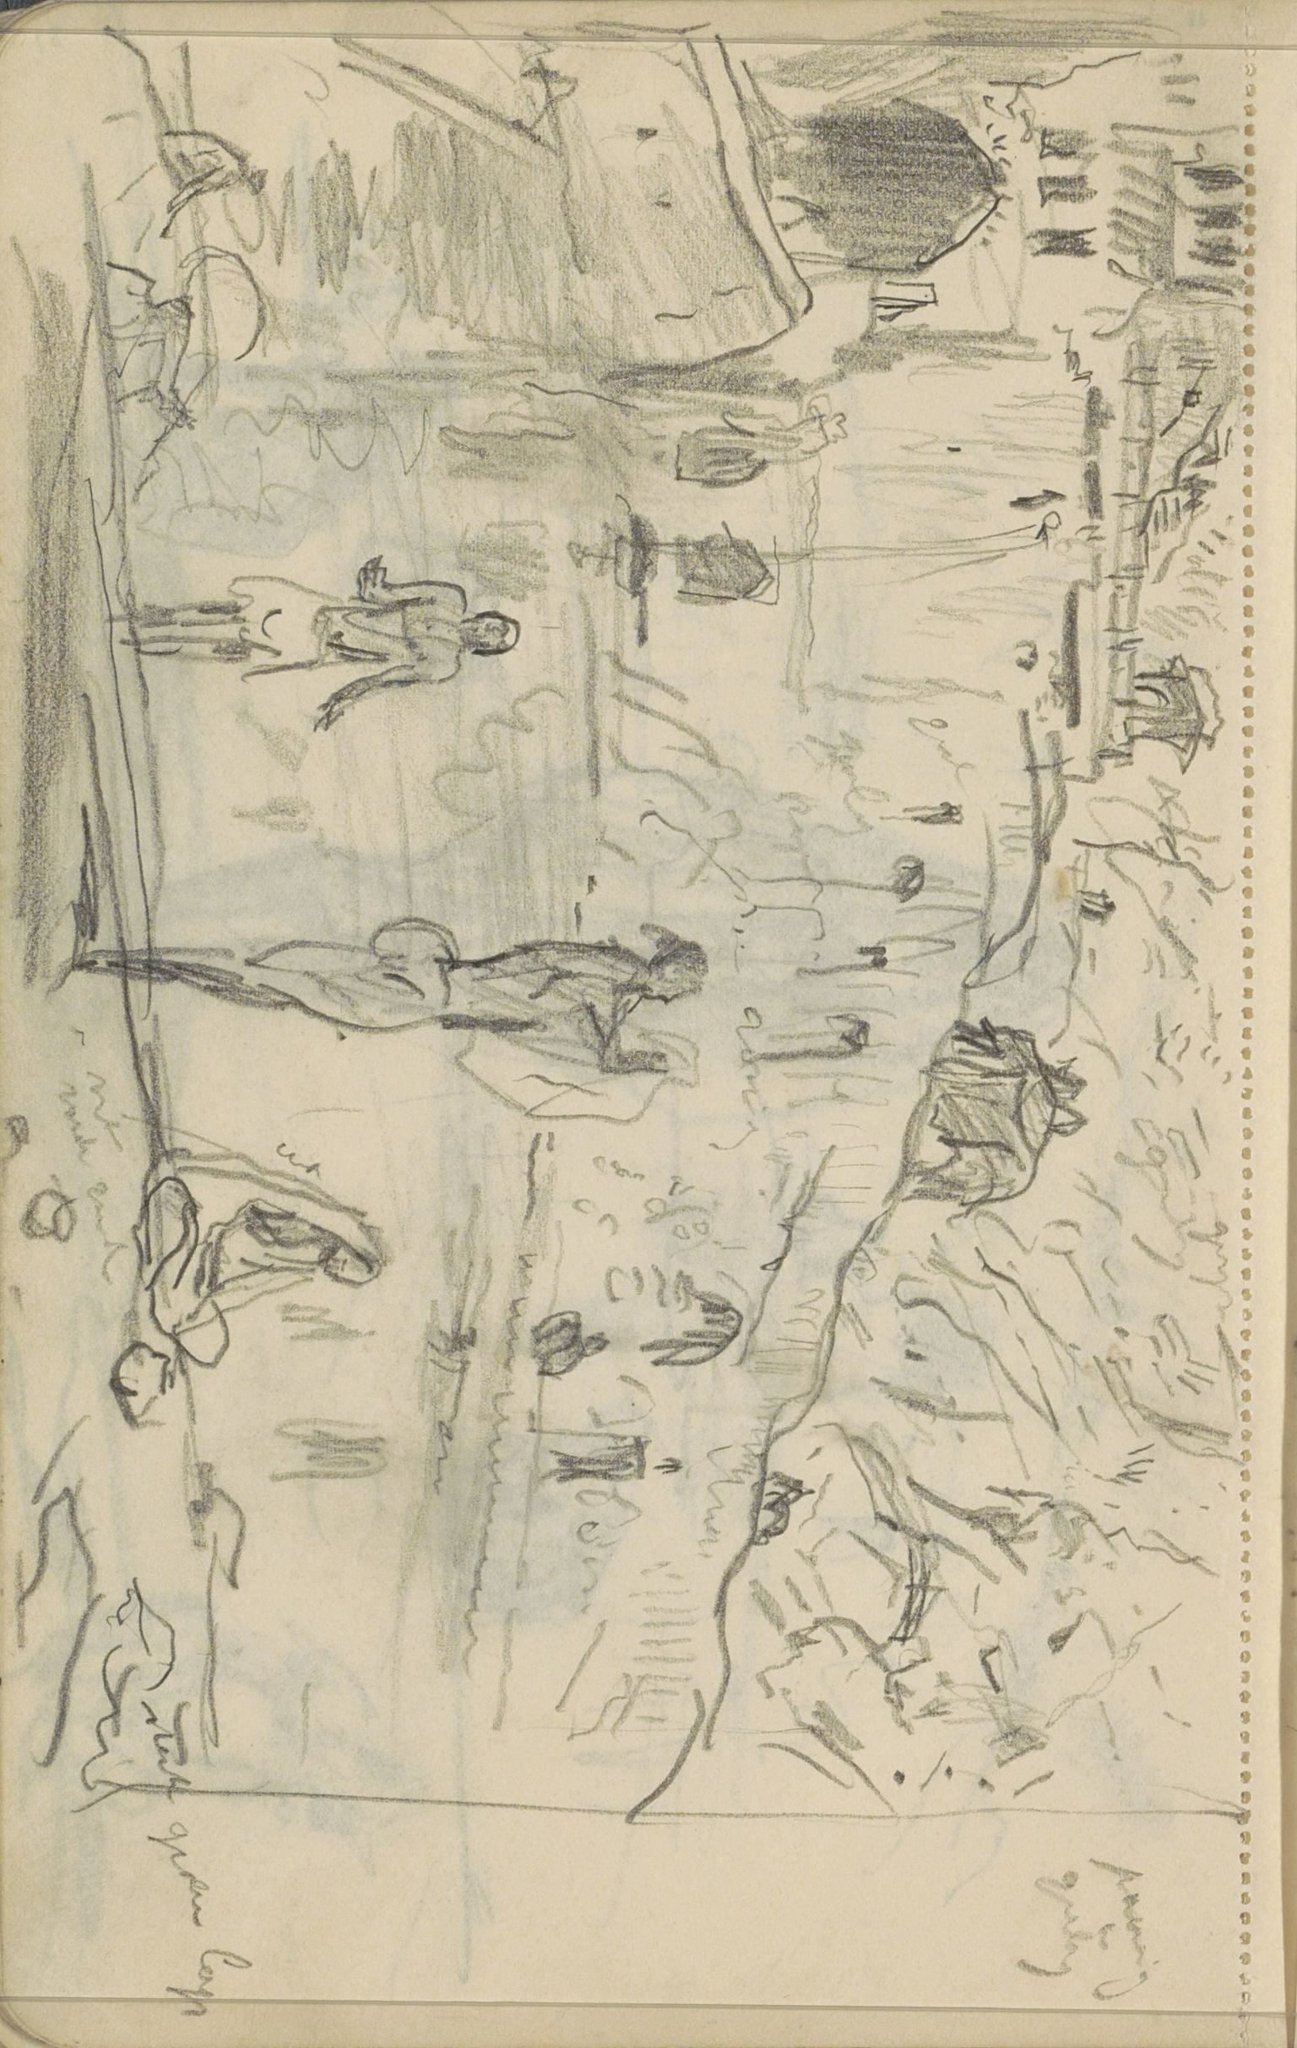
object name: sketchbook leaf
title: Landschap met huizen op een heuvel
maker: marius bauer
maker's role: draughtsman, print maker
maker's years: 1867-1932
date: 1924-1925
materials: paper, pencil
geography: india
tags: city-view, and landscape with man-made constructions, (high) hill, landscapes (+ landscape with figures, staffage), asiatic races and peoples: indians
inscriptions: kleurnotitie, handgeschreven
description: Op de voorgrond enkele Indiërs op een vlak stuk grond, mogelijk een strand. Pagina 88 uit een schetsboek met 87 bladen.